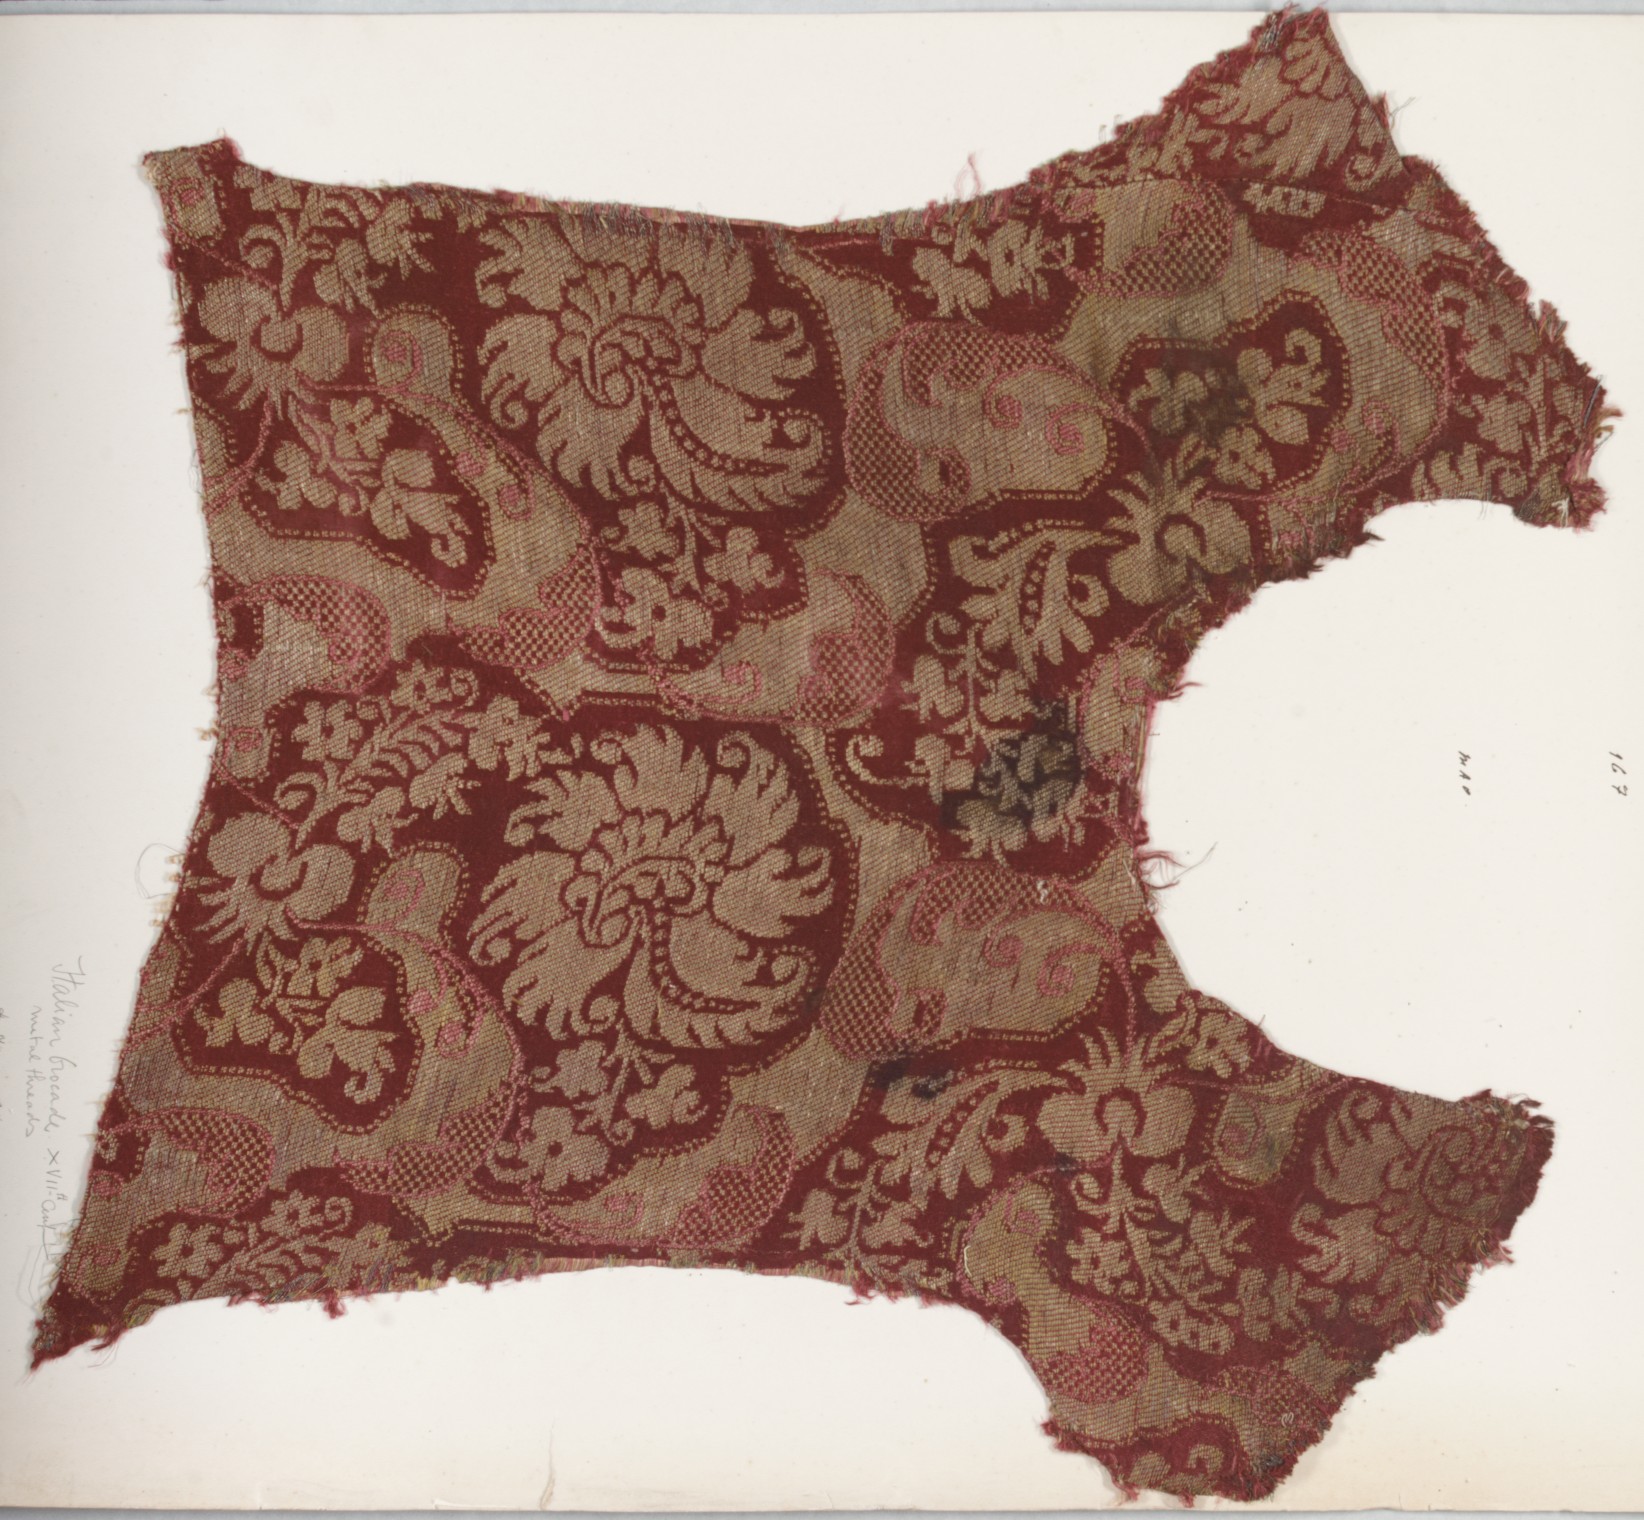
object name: fragment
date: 1601-1700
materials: metal thread, silk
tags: flowers,leaves